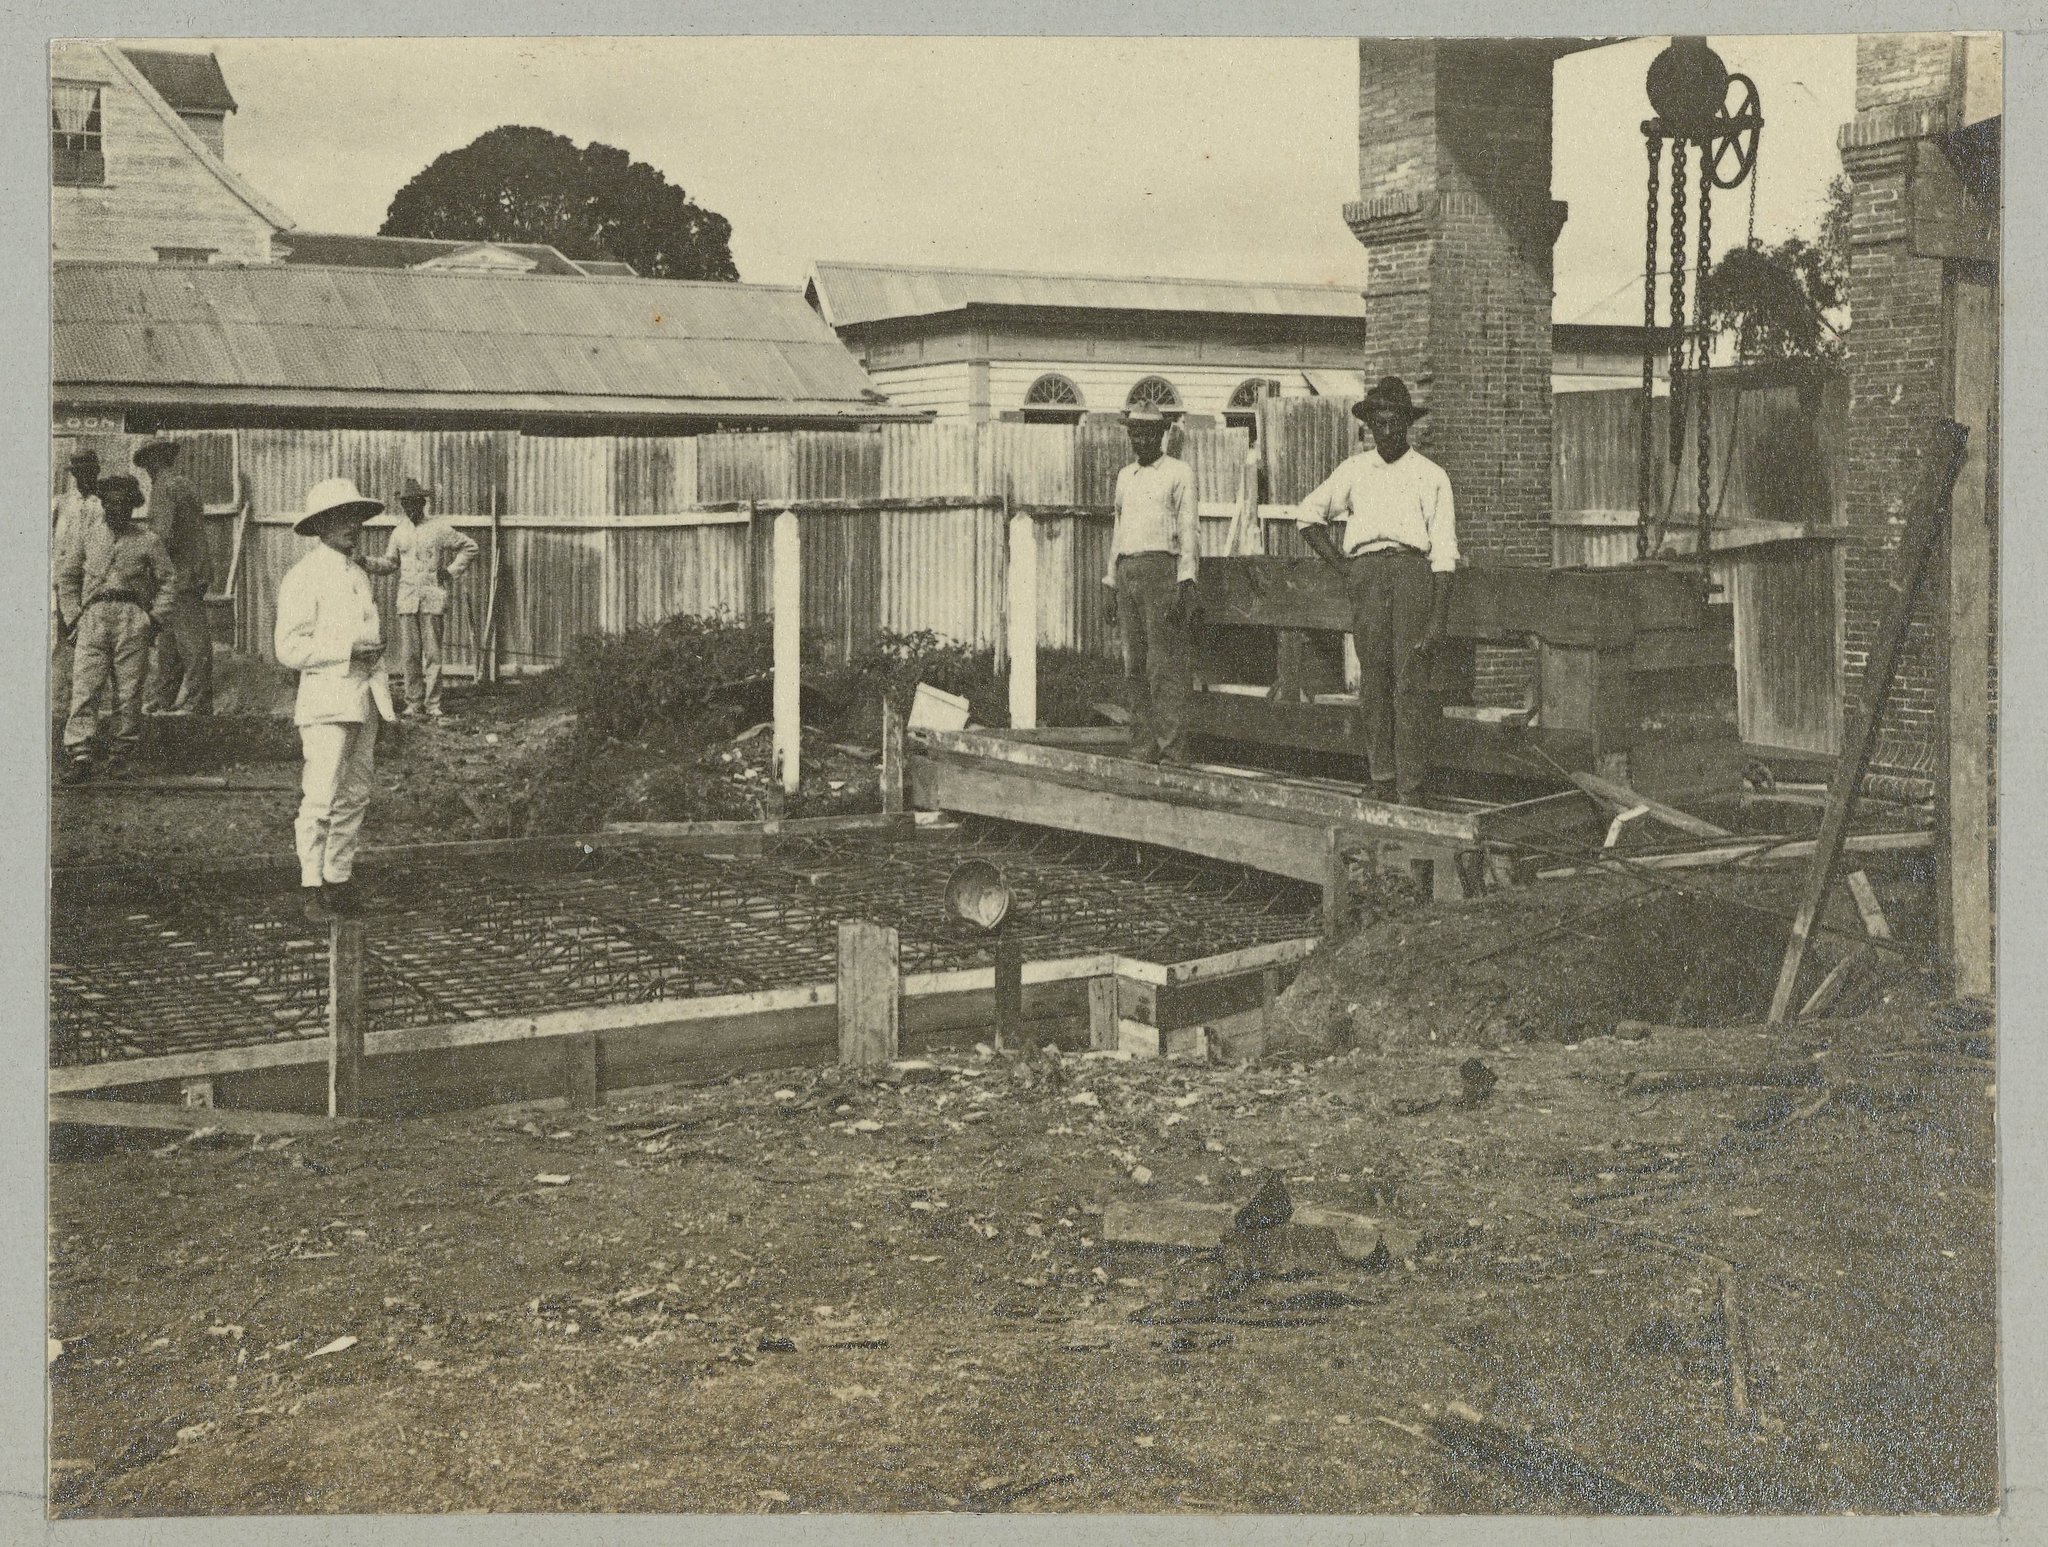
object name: photograph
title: Opzichter Nieuwenhuis bij brug Knuffelsgracht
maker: hendrik doijer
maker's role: engineer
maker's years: 1863-1925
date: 1903-1910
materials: photographic support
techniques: gelatin silver print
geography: suriname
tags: suriname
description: De Nederlandse opzichter Nieuwenhuis staande bij werkzaamheden aan de bouw van de brug over de Knuffelsgracht te Paramaribo. Onderdeel van het fotoalbum Souvenir de Voyage (deel 1), over het leven van de familie Doijer in en rond de plantage Ma Retraite in Suriname in de jaren 1903-1910.